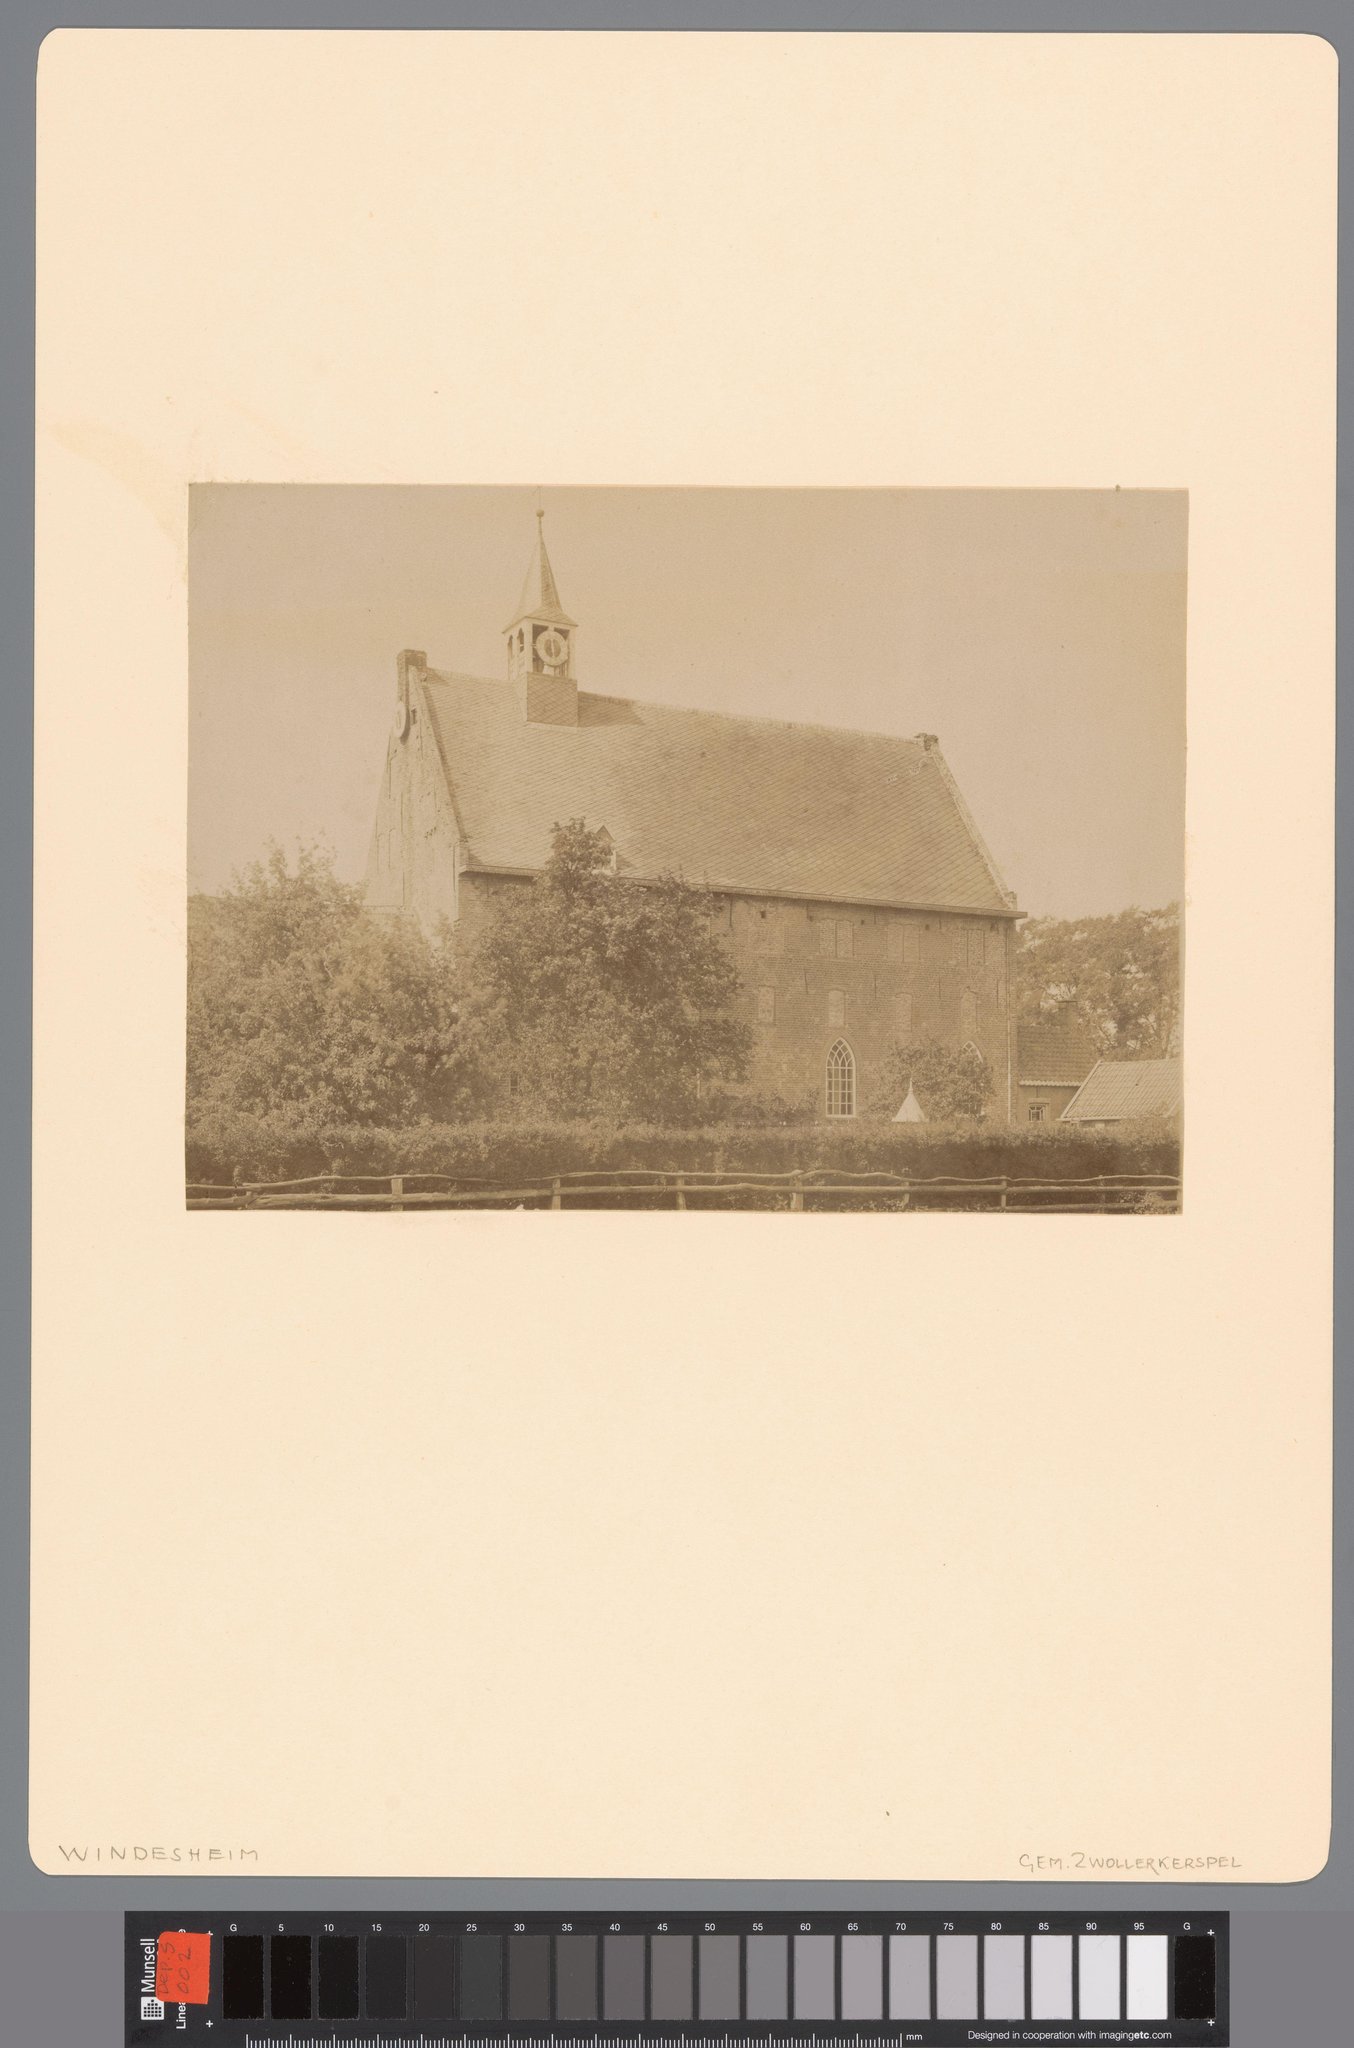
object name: photograph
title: Gezicht op de kerk van Windesheim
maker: anoniem (monumentenzorg)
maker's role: fotograaf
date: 1901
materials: cardboard, photographic support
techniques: albumen print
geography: windesheim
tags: church (exterior)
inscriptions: annotation: ‘Windesheim (O.IJ.) Kerk der N.H. gemeente Mei 1911/ gem. Zwollerkerspel’, annotation: ‘Windesheim/ gem. Zwollerkerspel’